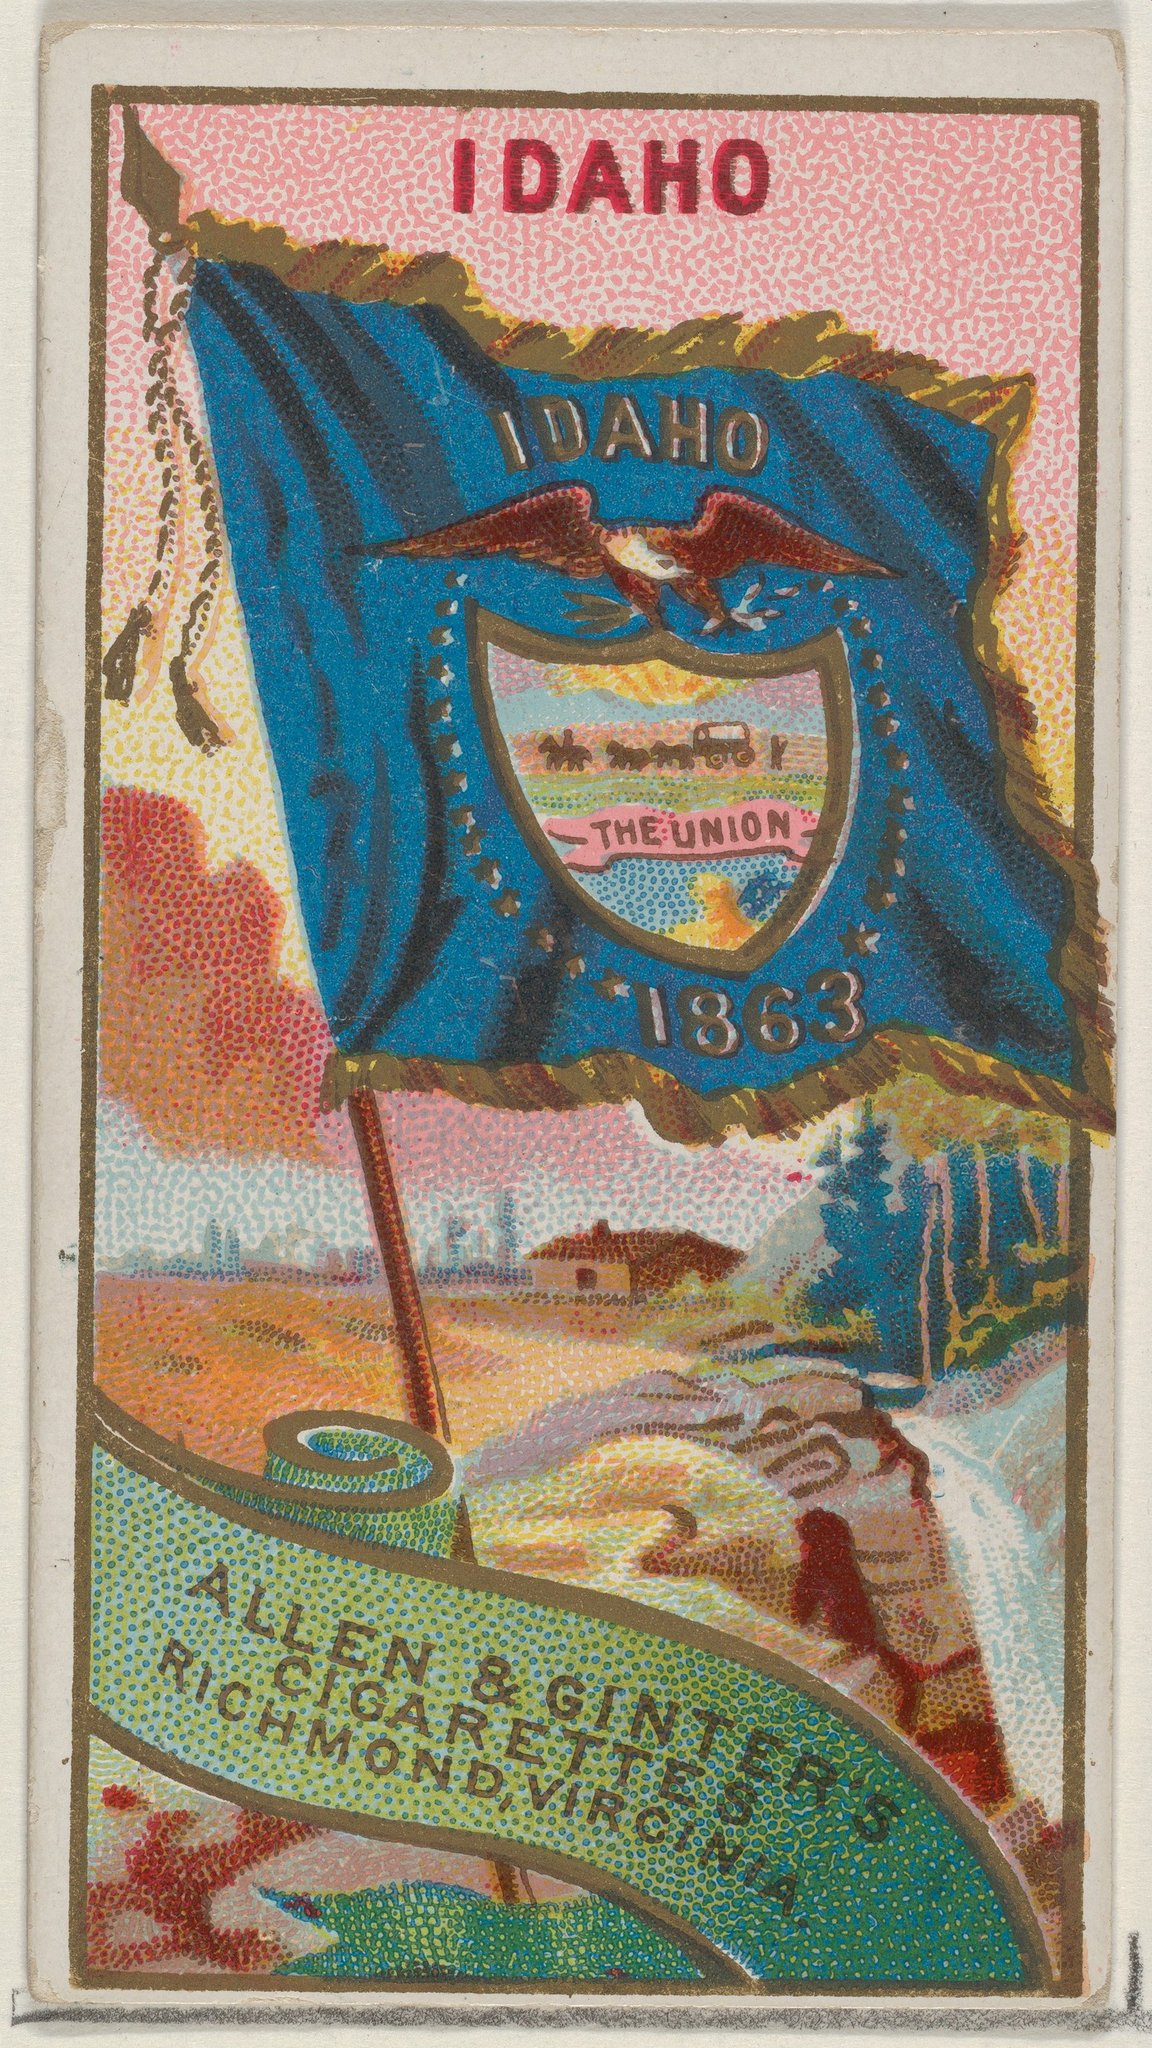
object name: print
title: Idaho, from Flags of the States and Territories (N11) for Allen & Ginter Cigarettes Brands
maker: allen & ginter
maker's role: publisher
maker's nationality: american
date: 1888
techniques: color lithograph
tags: flags